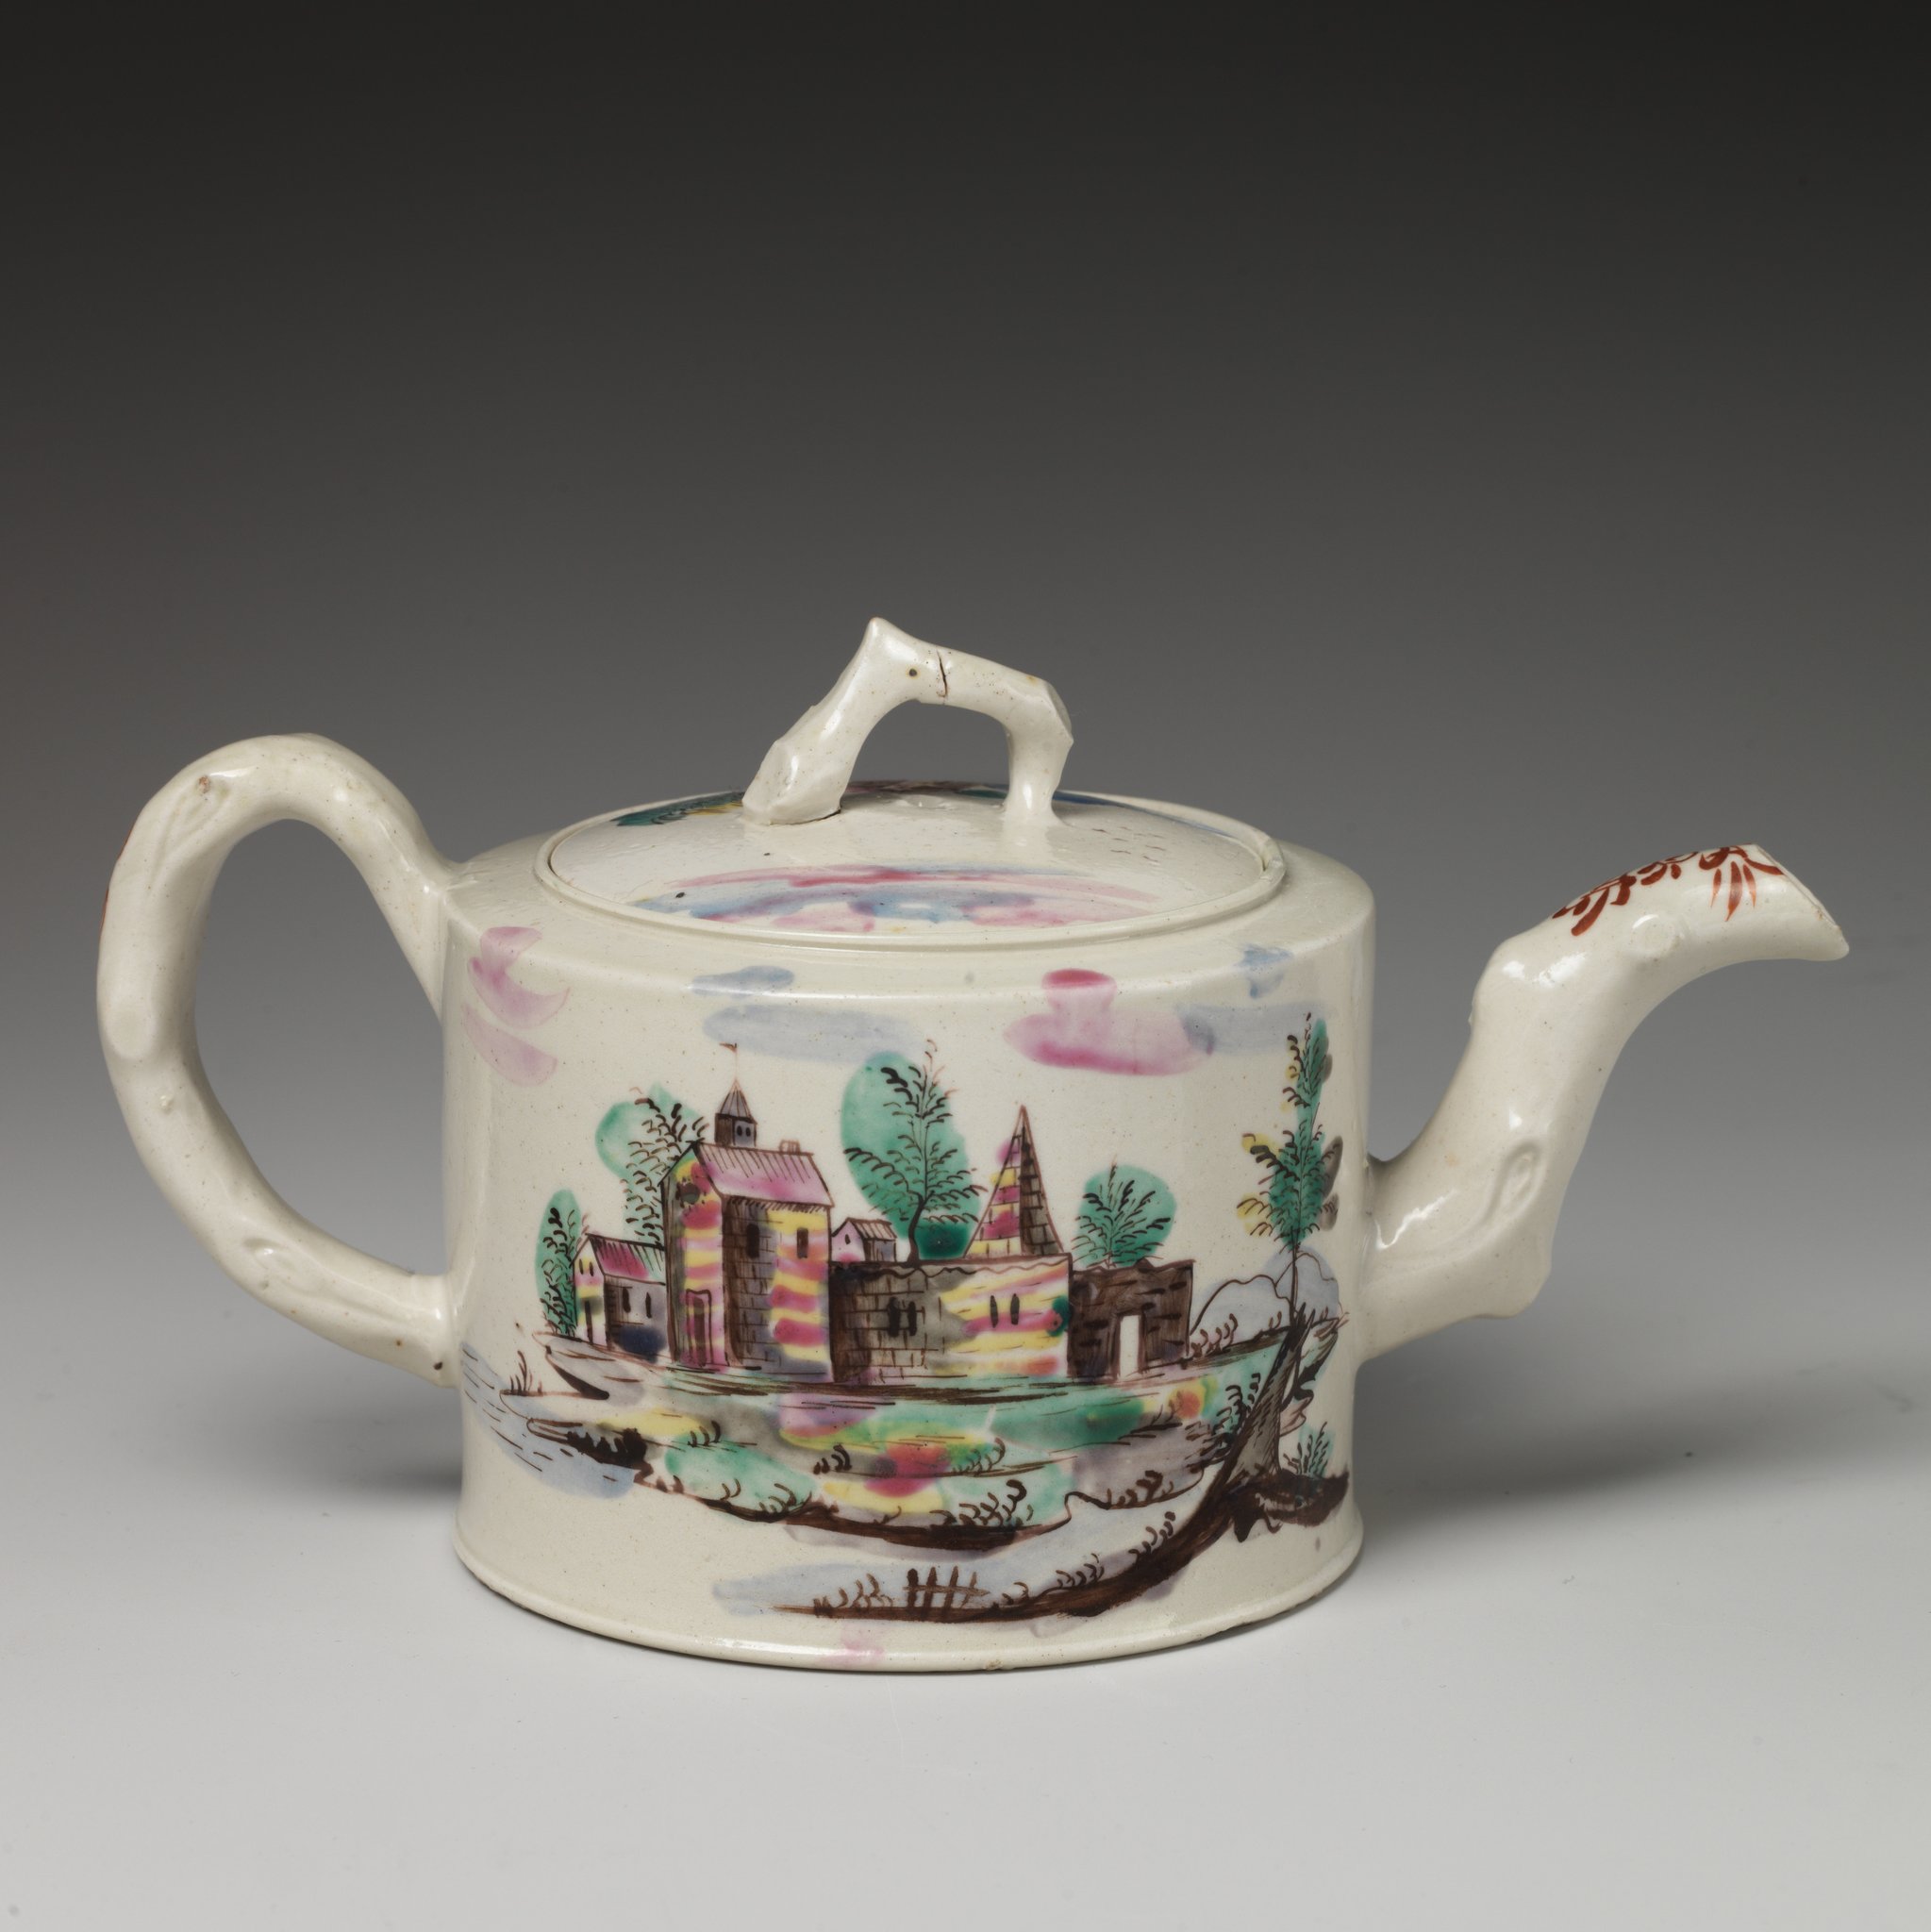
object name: teapot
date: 1760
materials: enamel, stoneware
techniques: salt glaze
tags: castles